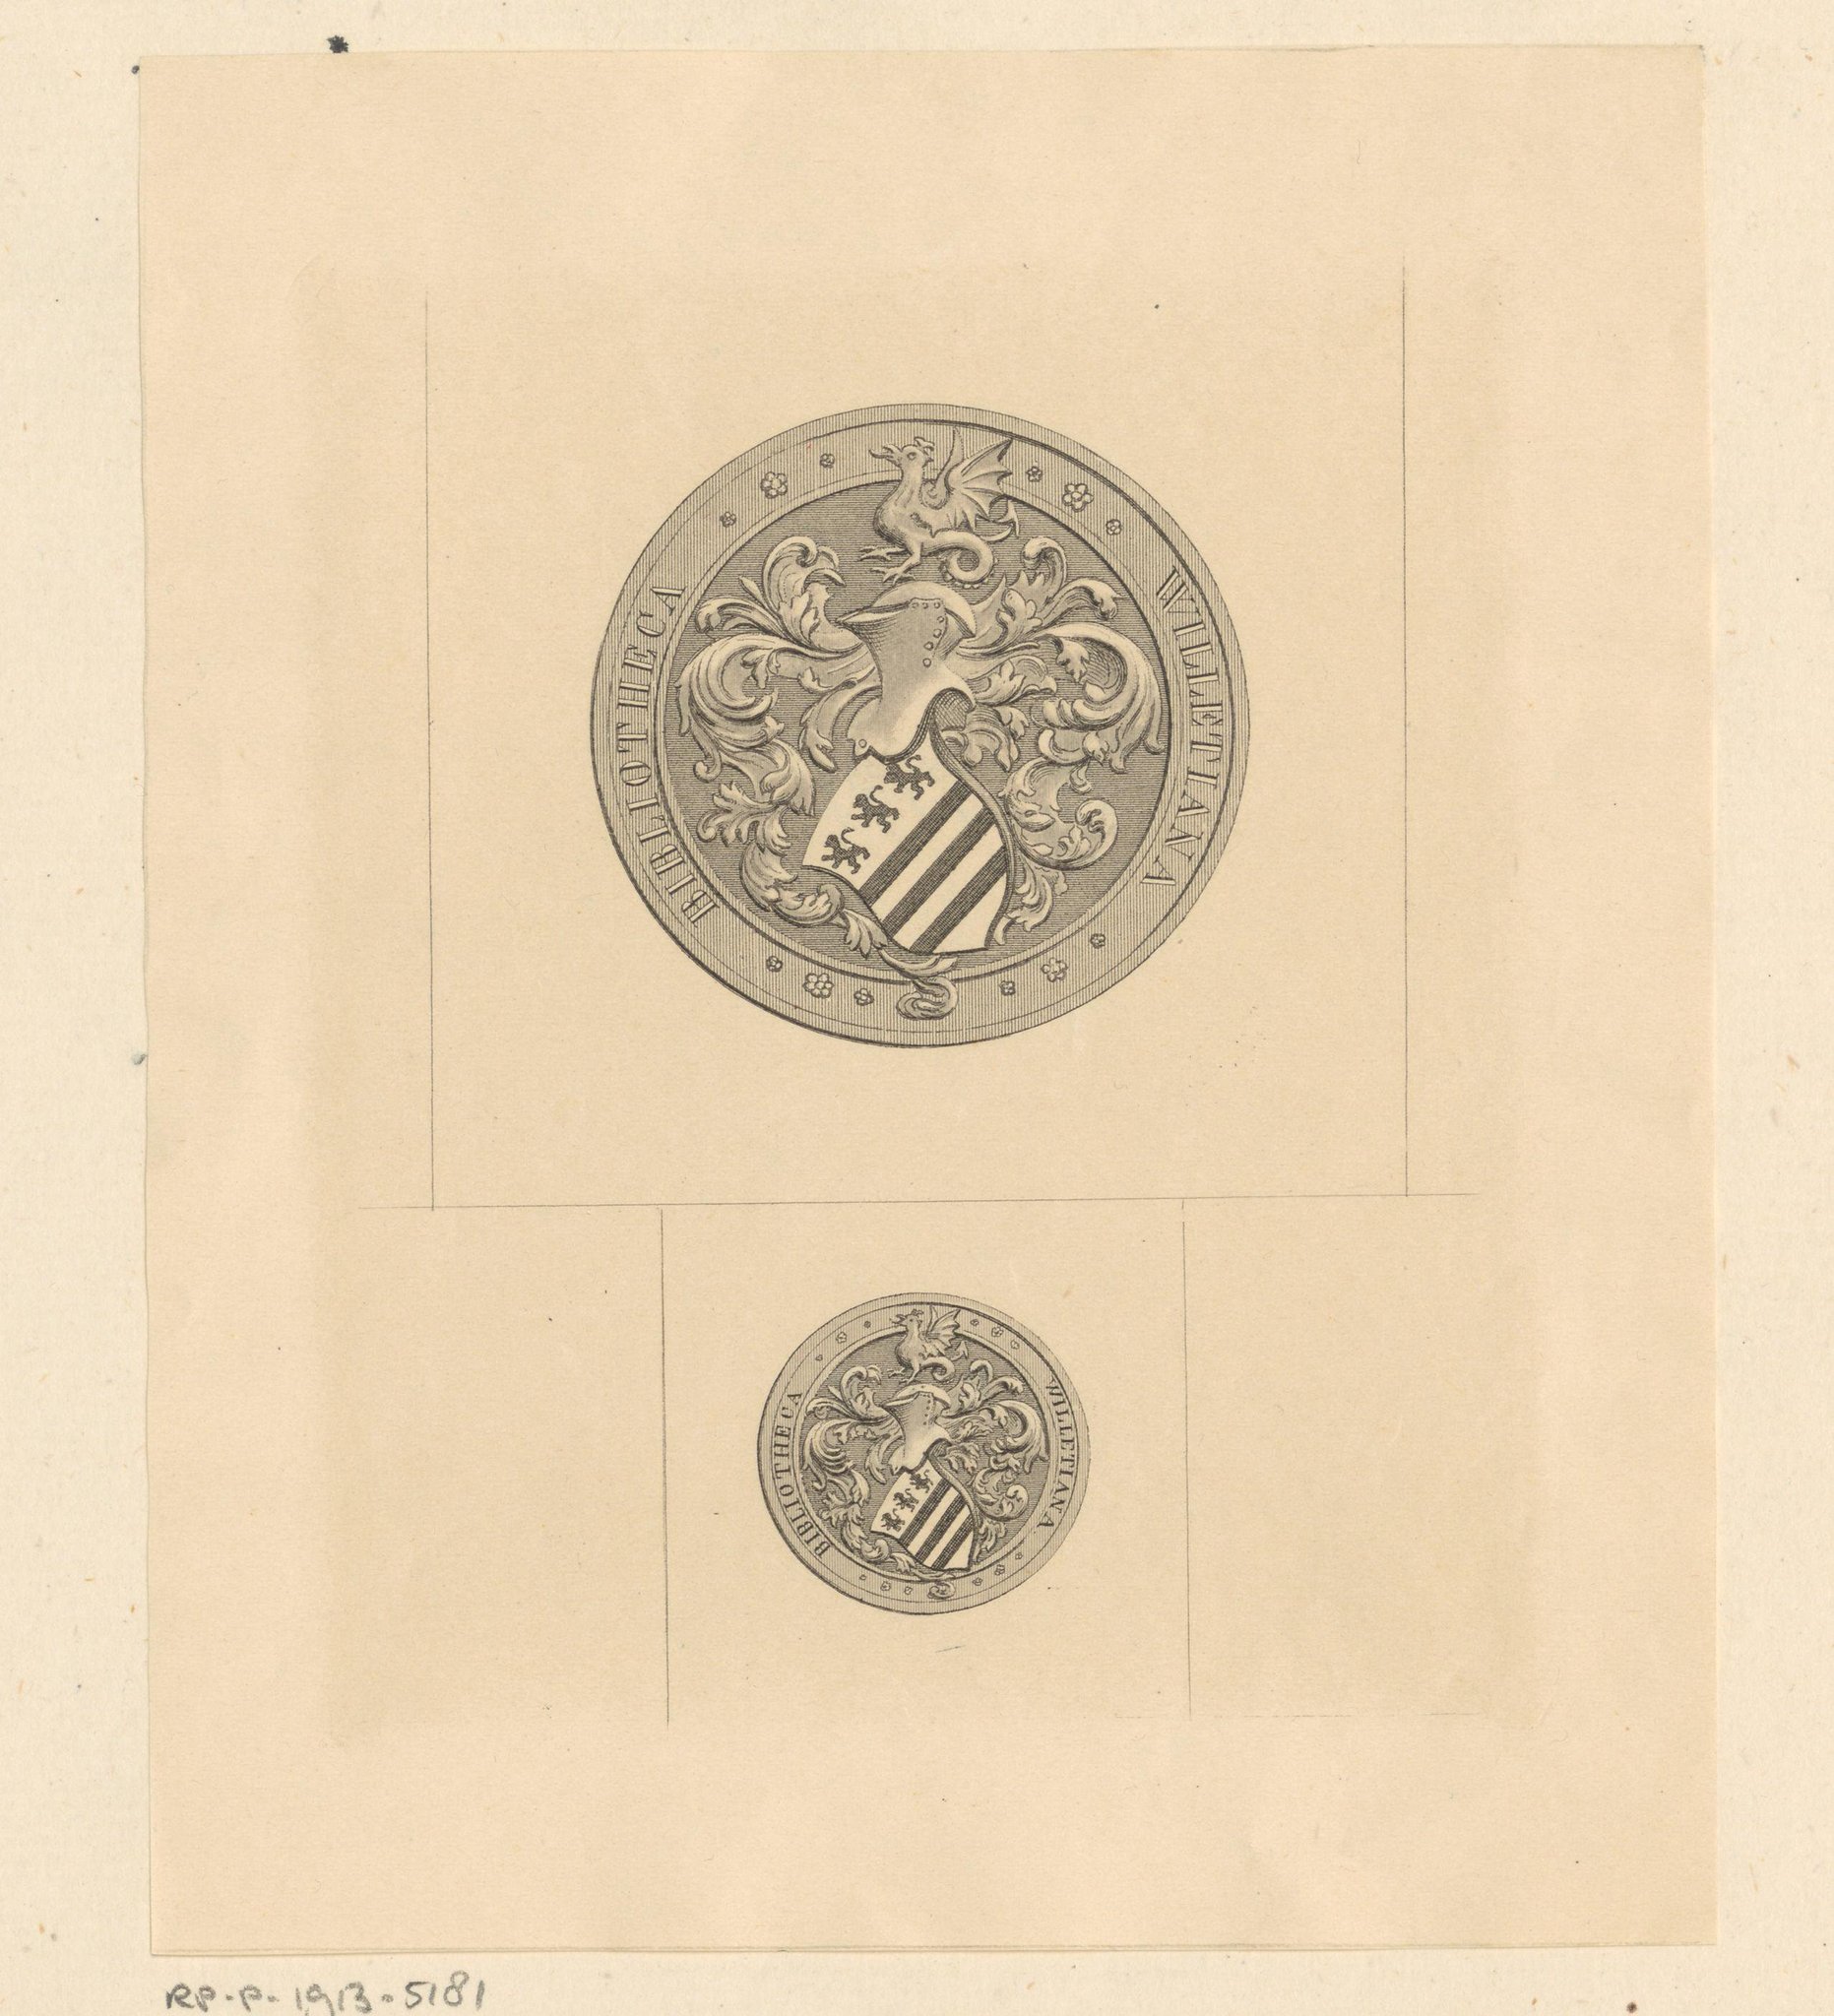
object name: bookplate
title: Ex libris van Abraham Willet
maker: Anonymous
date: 1870-1913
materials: paper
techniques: engraving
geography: netherlands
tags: amsterdam, dragon, armorial bearing, heraldry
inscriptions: collector's mark: Lugt 2760, collector's mark: Lugt 2233